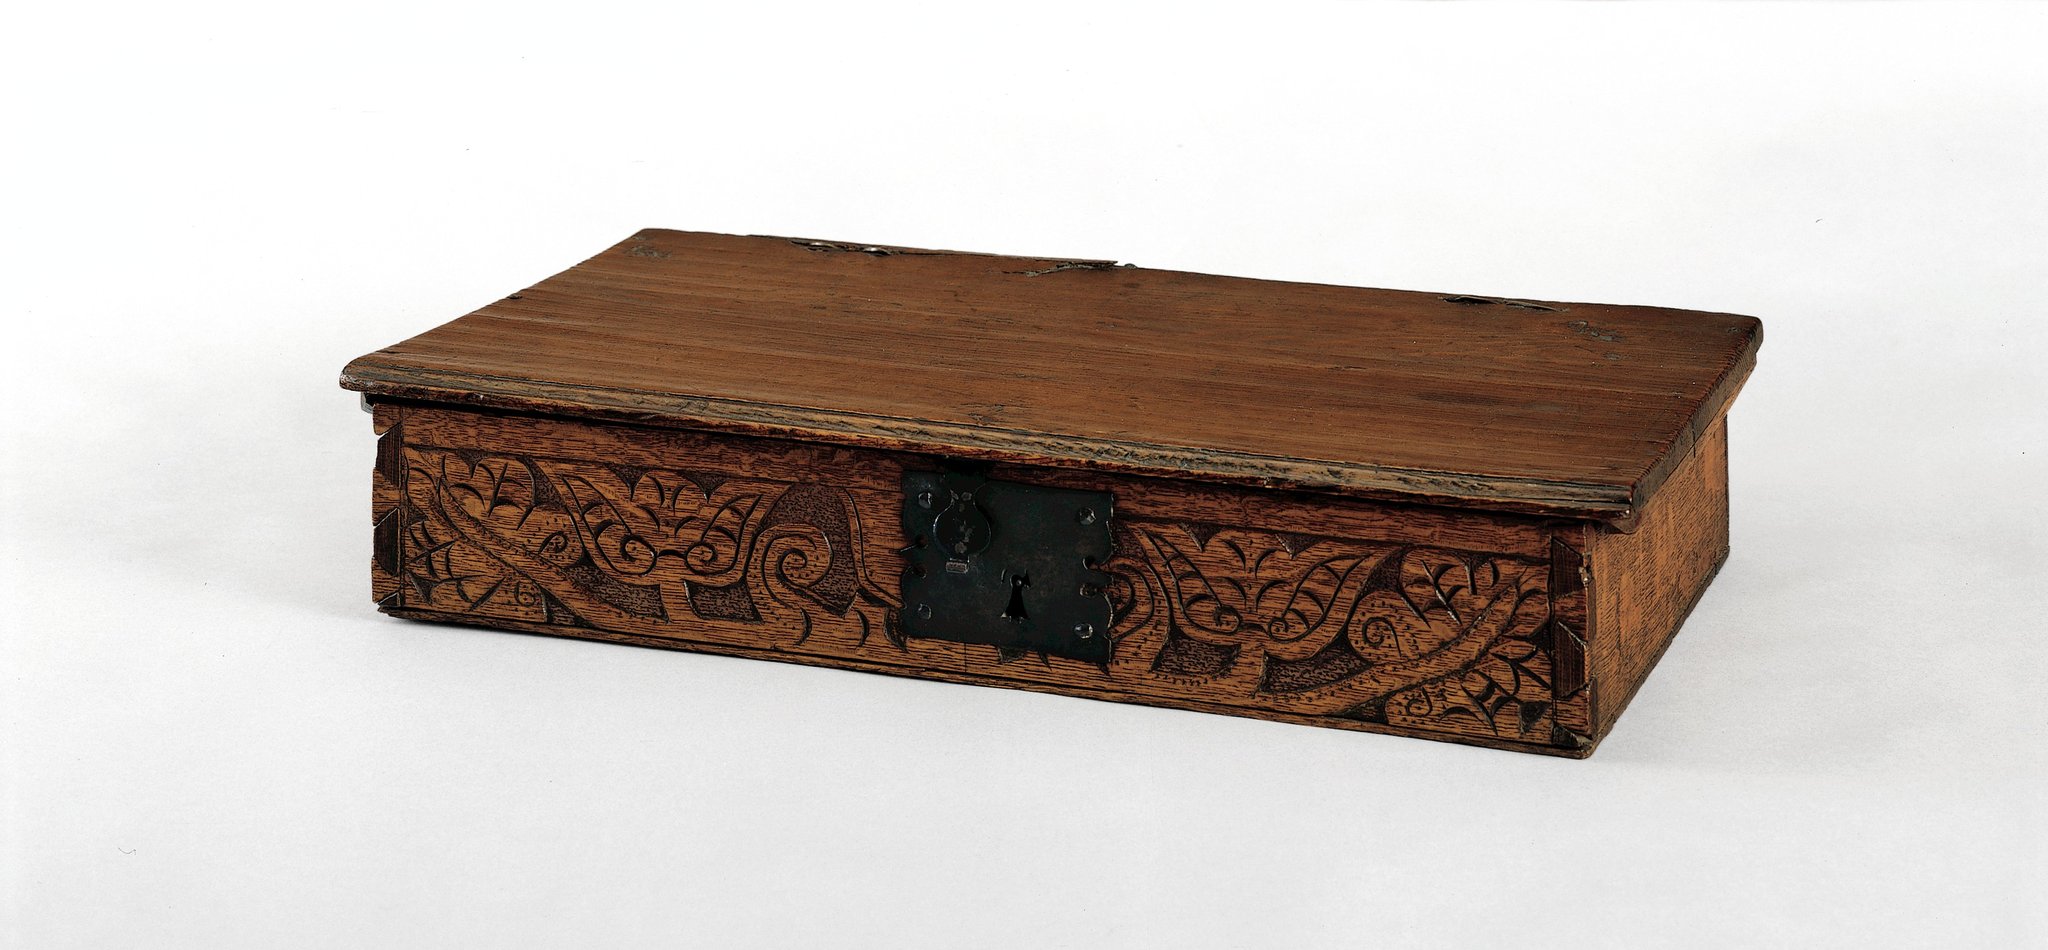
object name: box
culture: american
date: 1690-1710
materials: wood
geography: united states